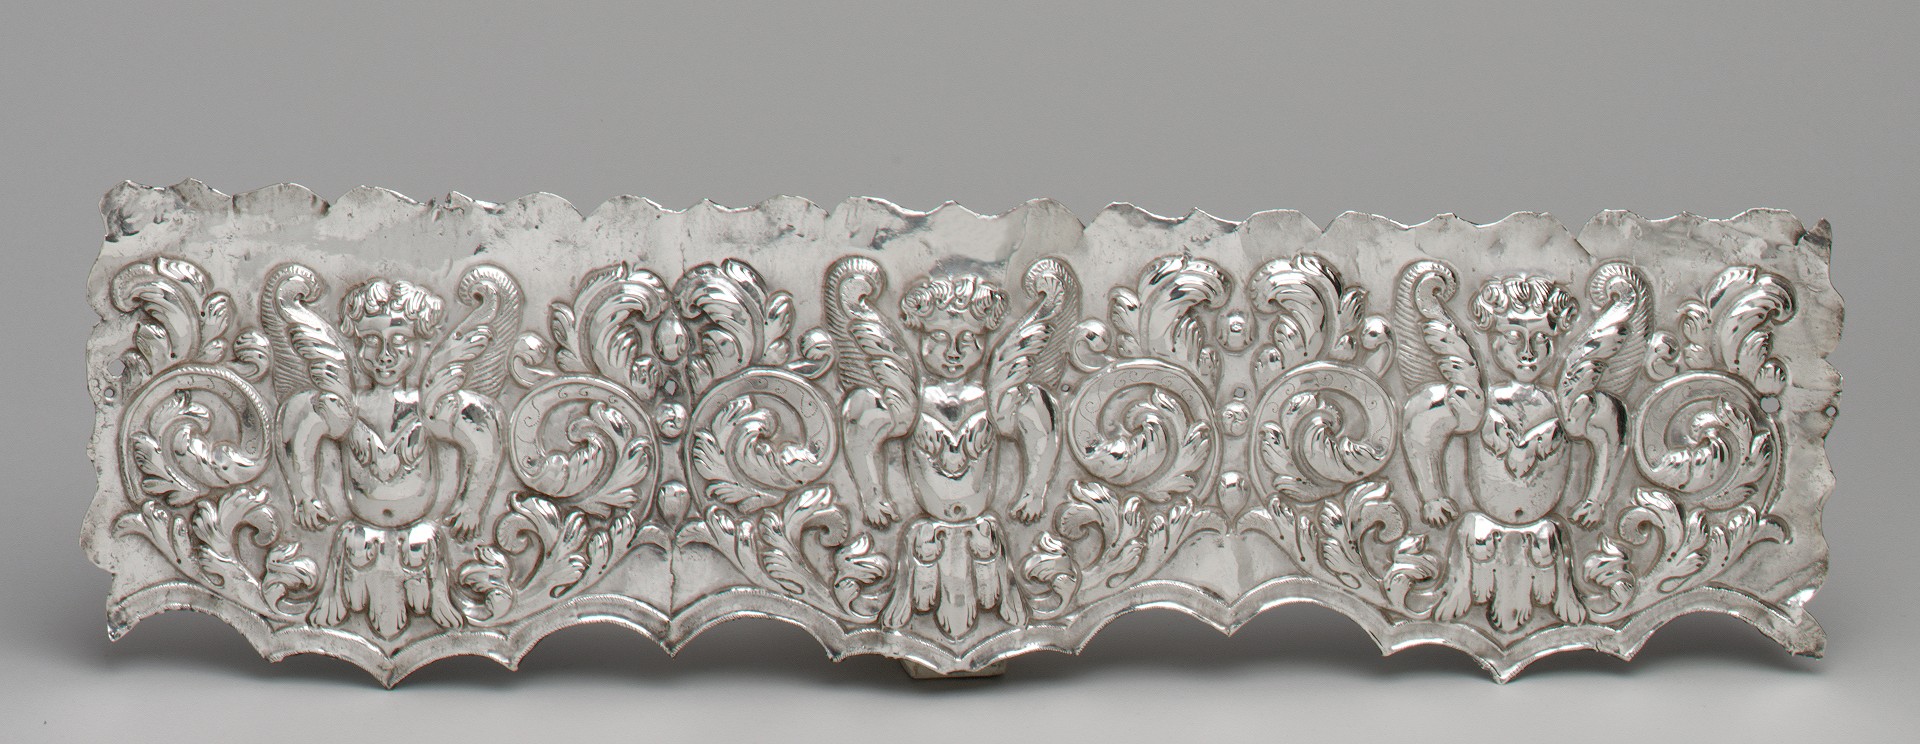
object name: plaque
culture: bolivian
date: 1667-1700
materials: silver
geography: paraguay